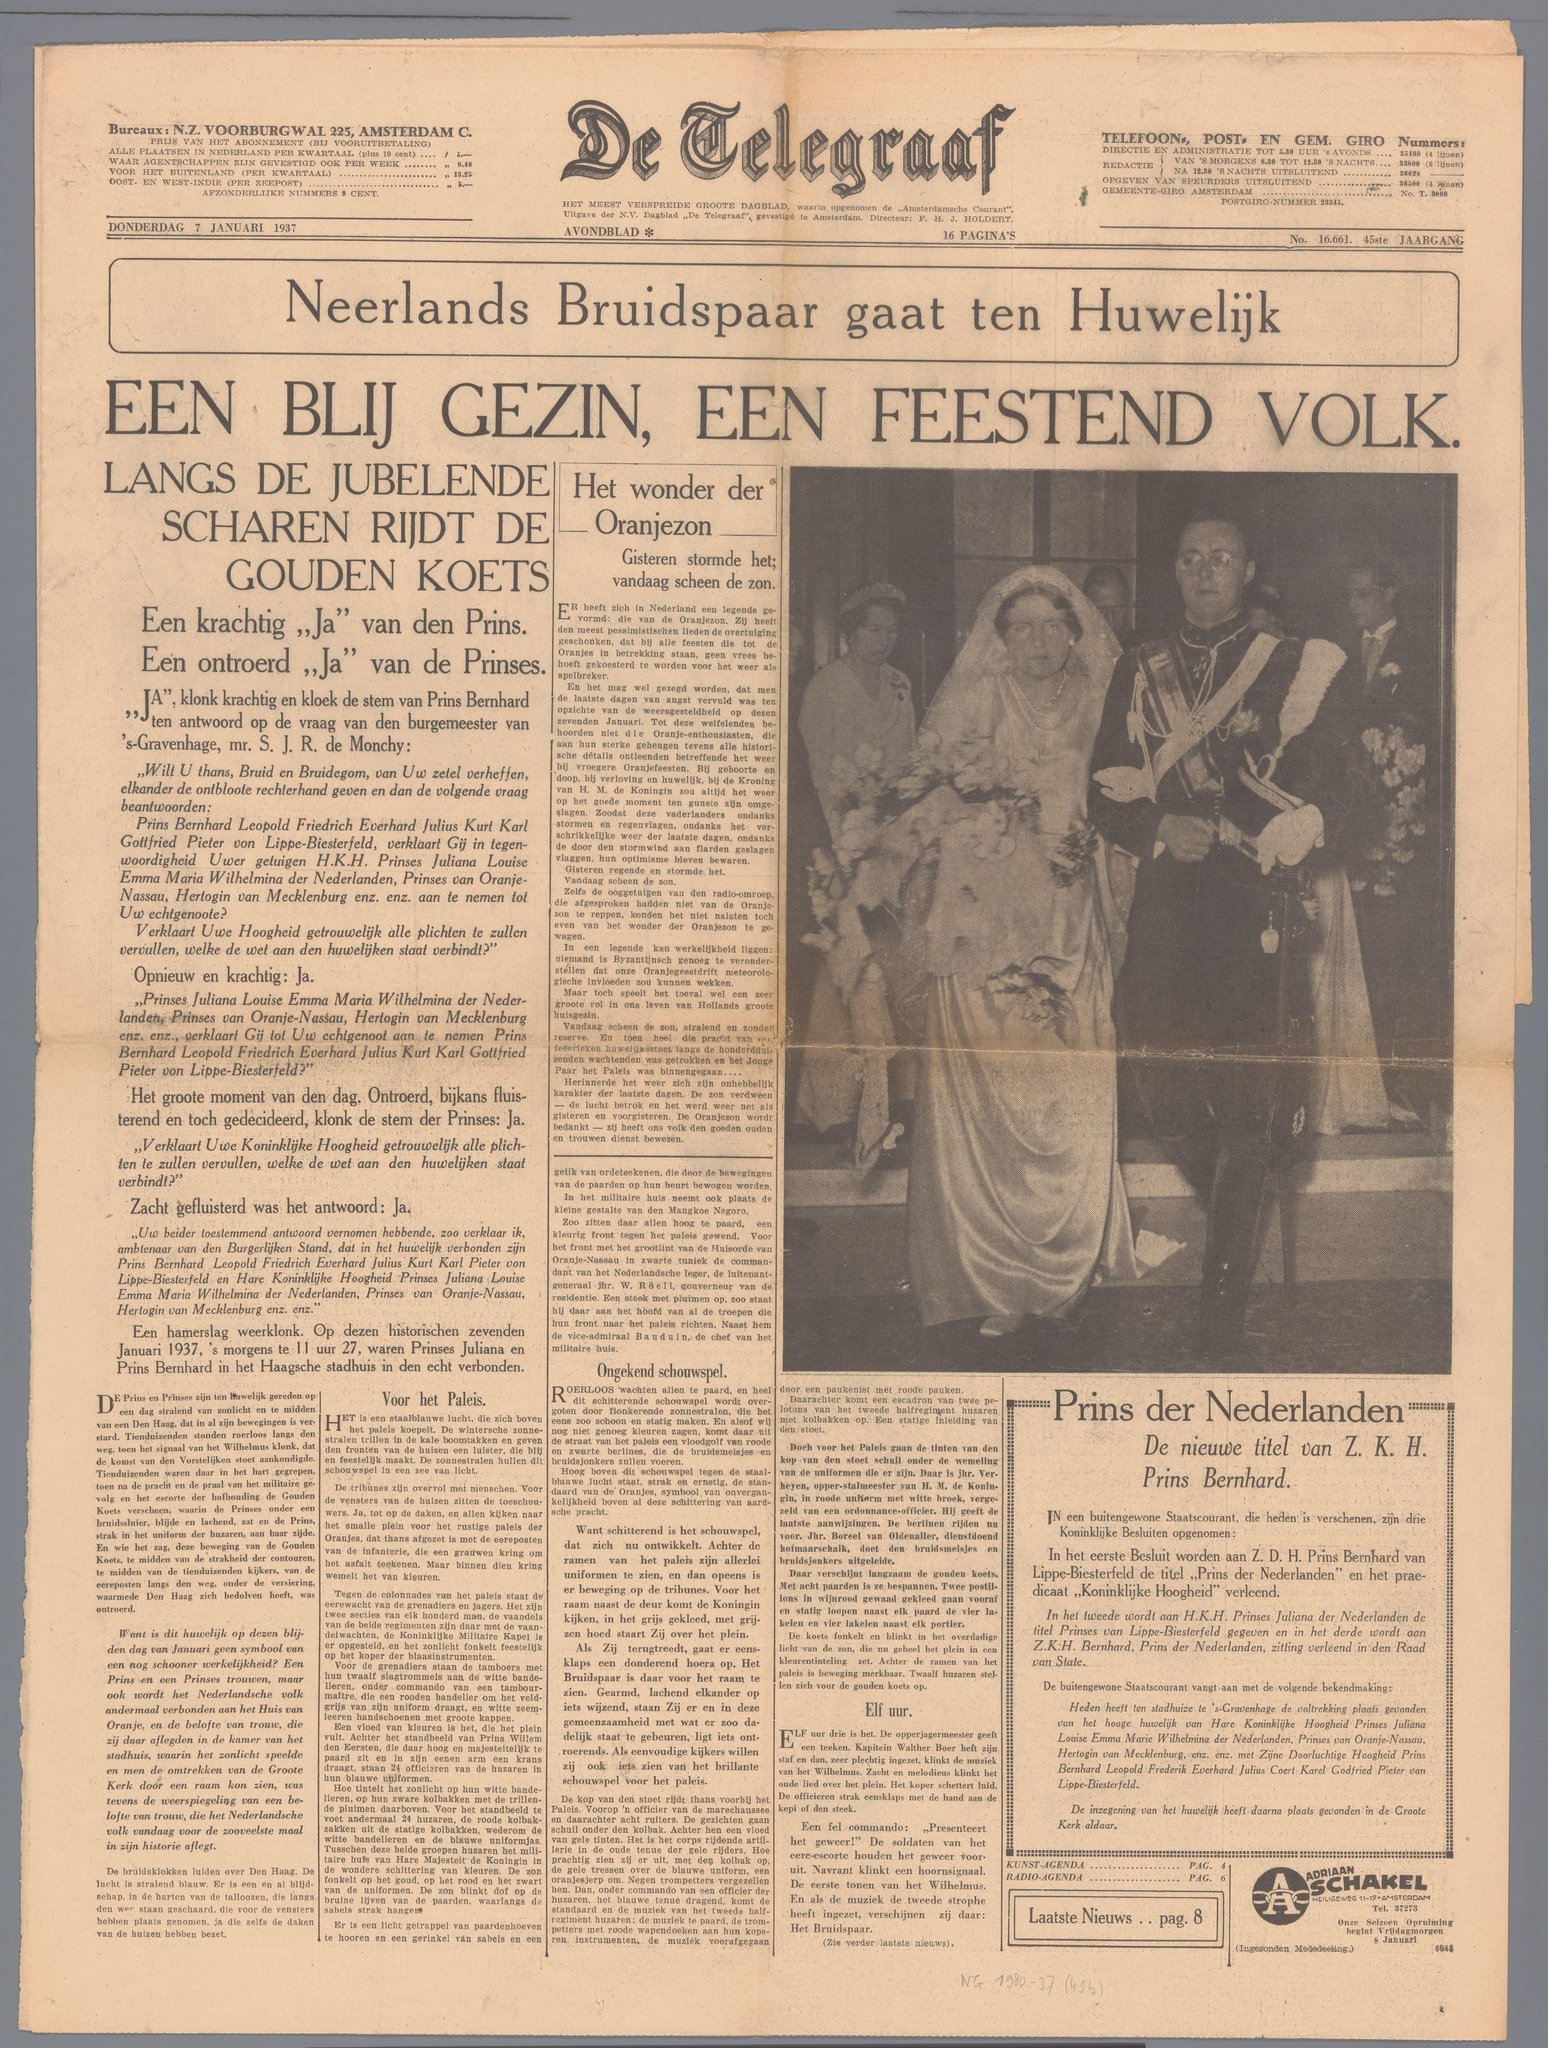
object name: newspaper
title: De Telegraaf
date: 1937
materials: paper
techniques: printing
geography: amsterdam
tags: utrecht, bernhard (prins der nederlanden), the hague, juliana of the netherlands, netherlands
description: Krant over het huwelijk van Juliana en Bernhard, nr. 16661 van de 45e jaargang van "De Telegraaf", 2.5 pp (van de oorspronkelijke 16 bladen).